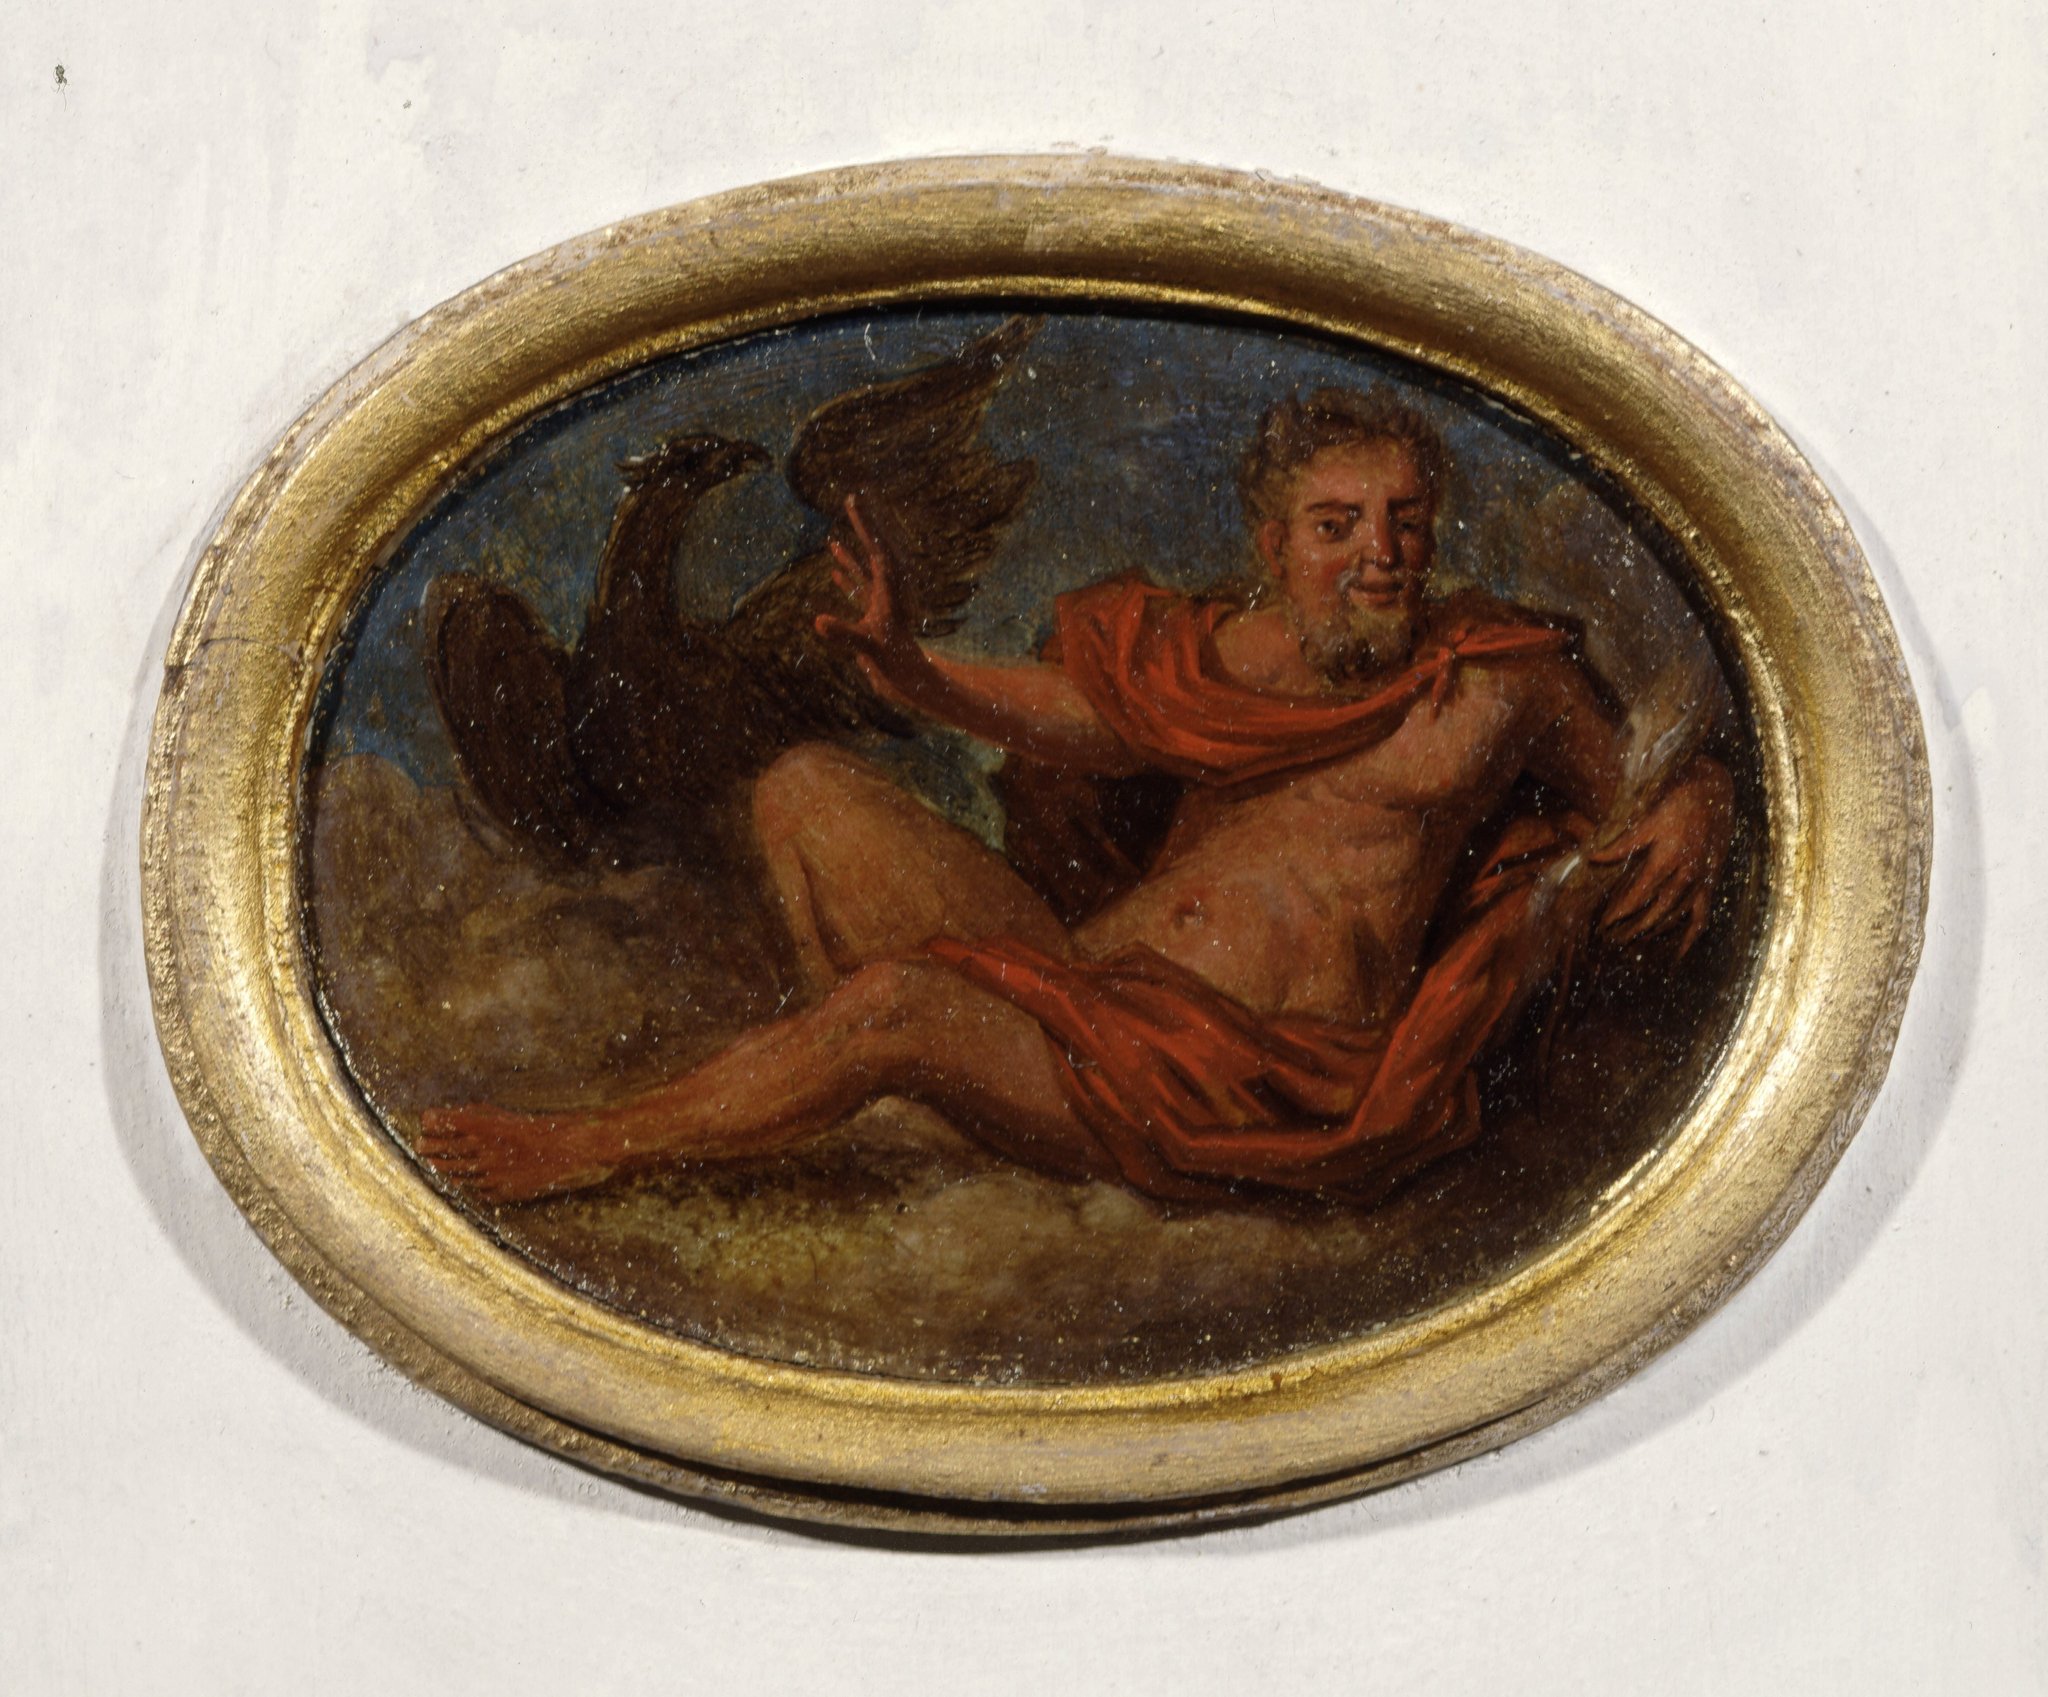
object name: painting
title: Jupiter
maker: Anonymous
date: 1690-1710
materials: oil, panel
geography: amsterdam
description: Schoorstenstuk, vast aangebracht in de kinderkamer van een poppenhuis, voorstellende Jupiter, achteroverzittend op de grond, met in zijn linkerarm 'donder en een bliksemschicht'. Rechts is op de achtergrond een adelaar zichtbaar. Het schilderij wordt omlijst door een gladde vergulde profiellijst.